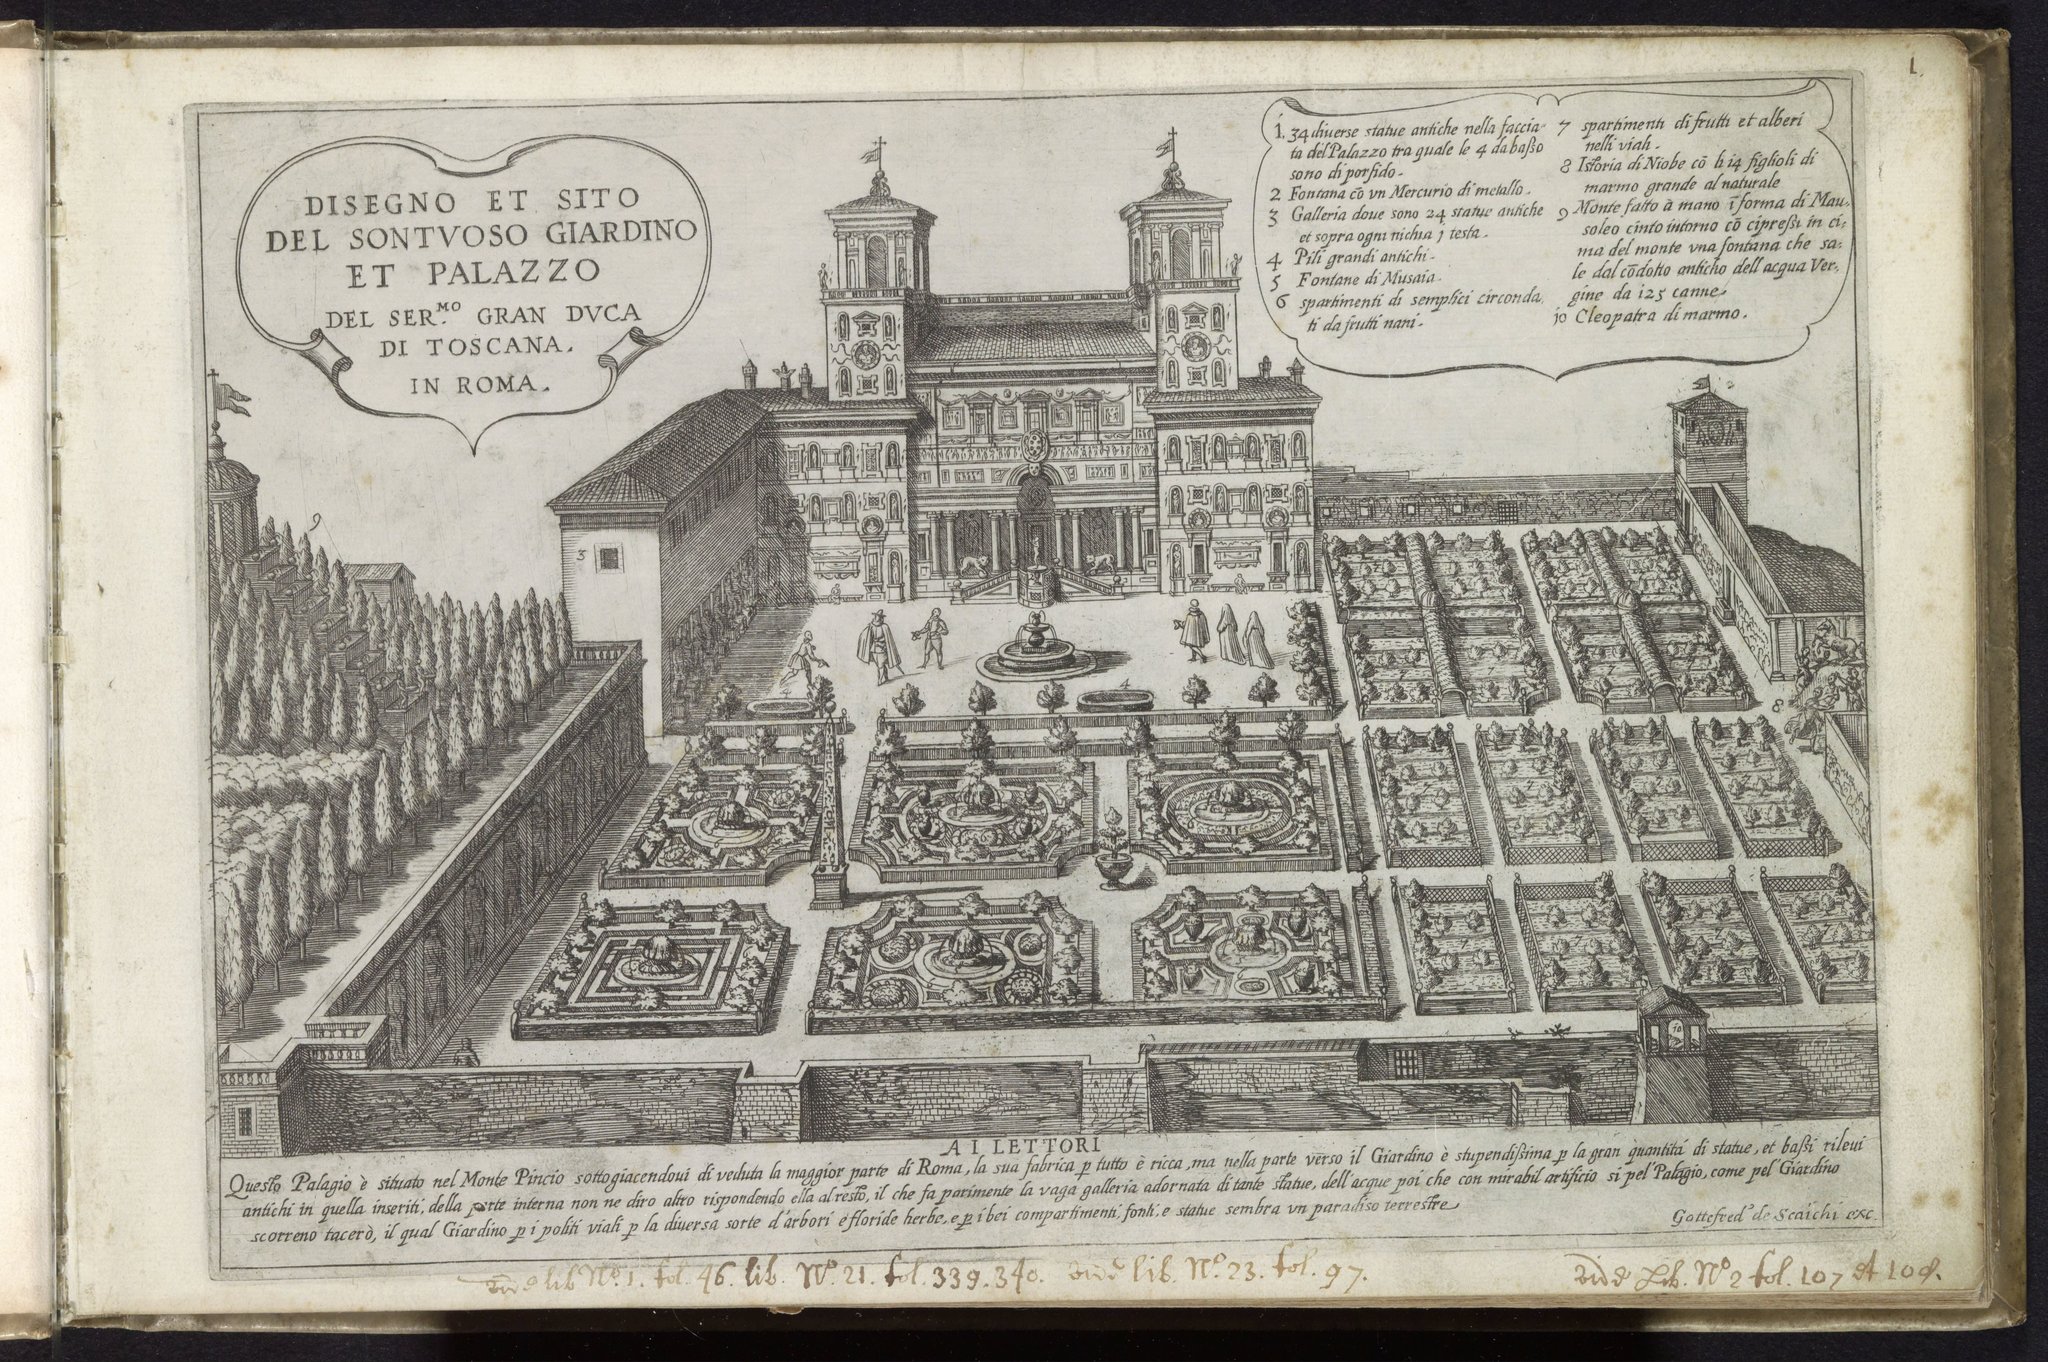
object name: print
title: Disegno et sito del sontovoso giardino et palazzo del ser.mo gran duca di Toscana, in Roma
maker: govert van schayck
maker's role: publisher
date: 1623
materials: paper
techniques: engraving, etching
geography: rome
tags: garden, garden fountain, hôtel, i.e. small palace in city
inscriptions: inscription: ‘Ende lib. No. 1. fol. 46. lib. No. 21. fol. 339. 340. Ende lib. No. 23. fol. 97. Ende lib. No. 2. fol. 107 et 108.’, number: ‘1’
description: Gezicht op de Villa Medici en tuin te Rome. Linksboven de titel in een cartouche. Rechtsboven een cartouche met een verklarende lijst met nummers. In de ondermarge een tekst in het Italiaans. Prent maakt deel uit van een album.